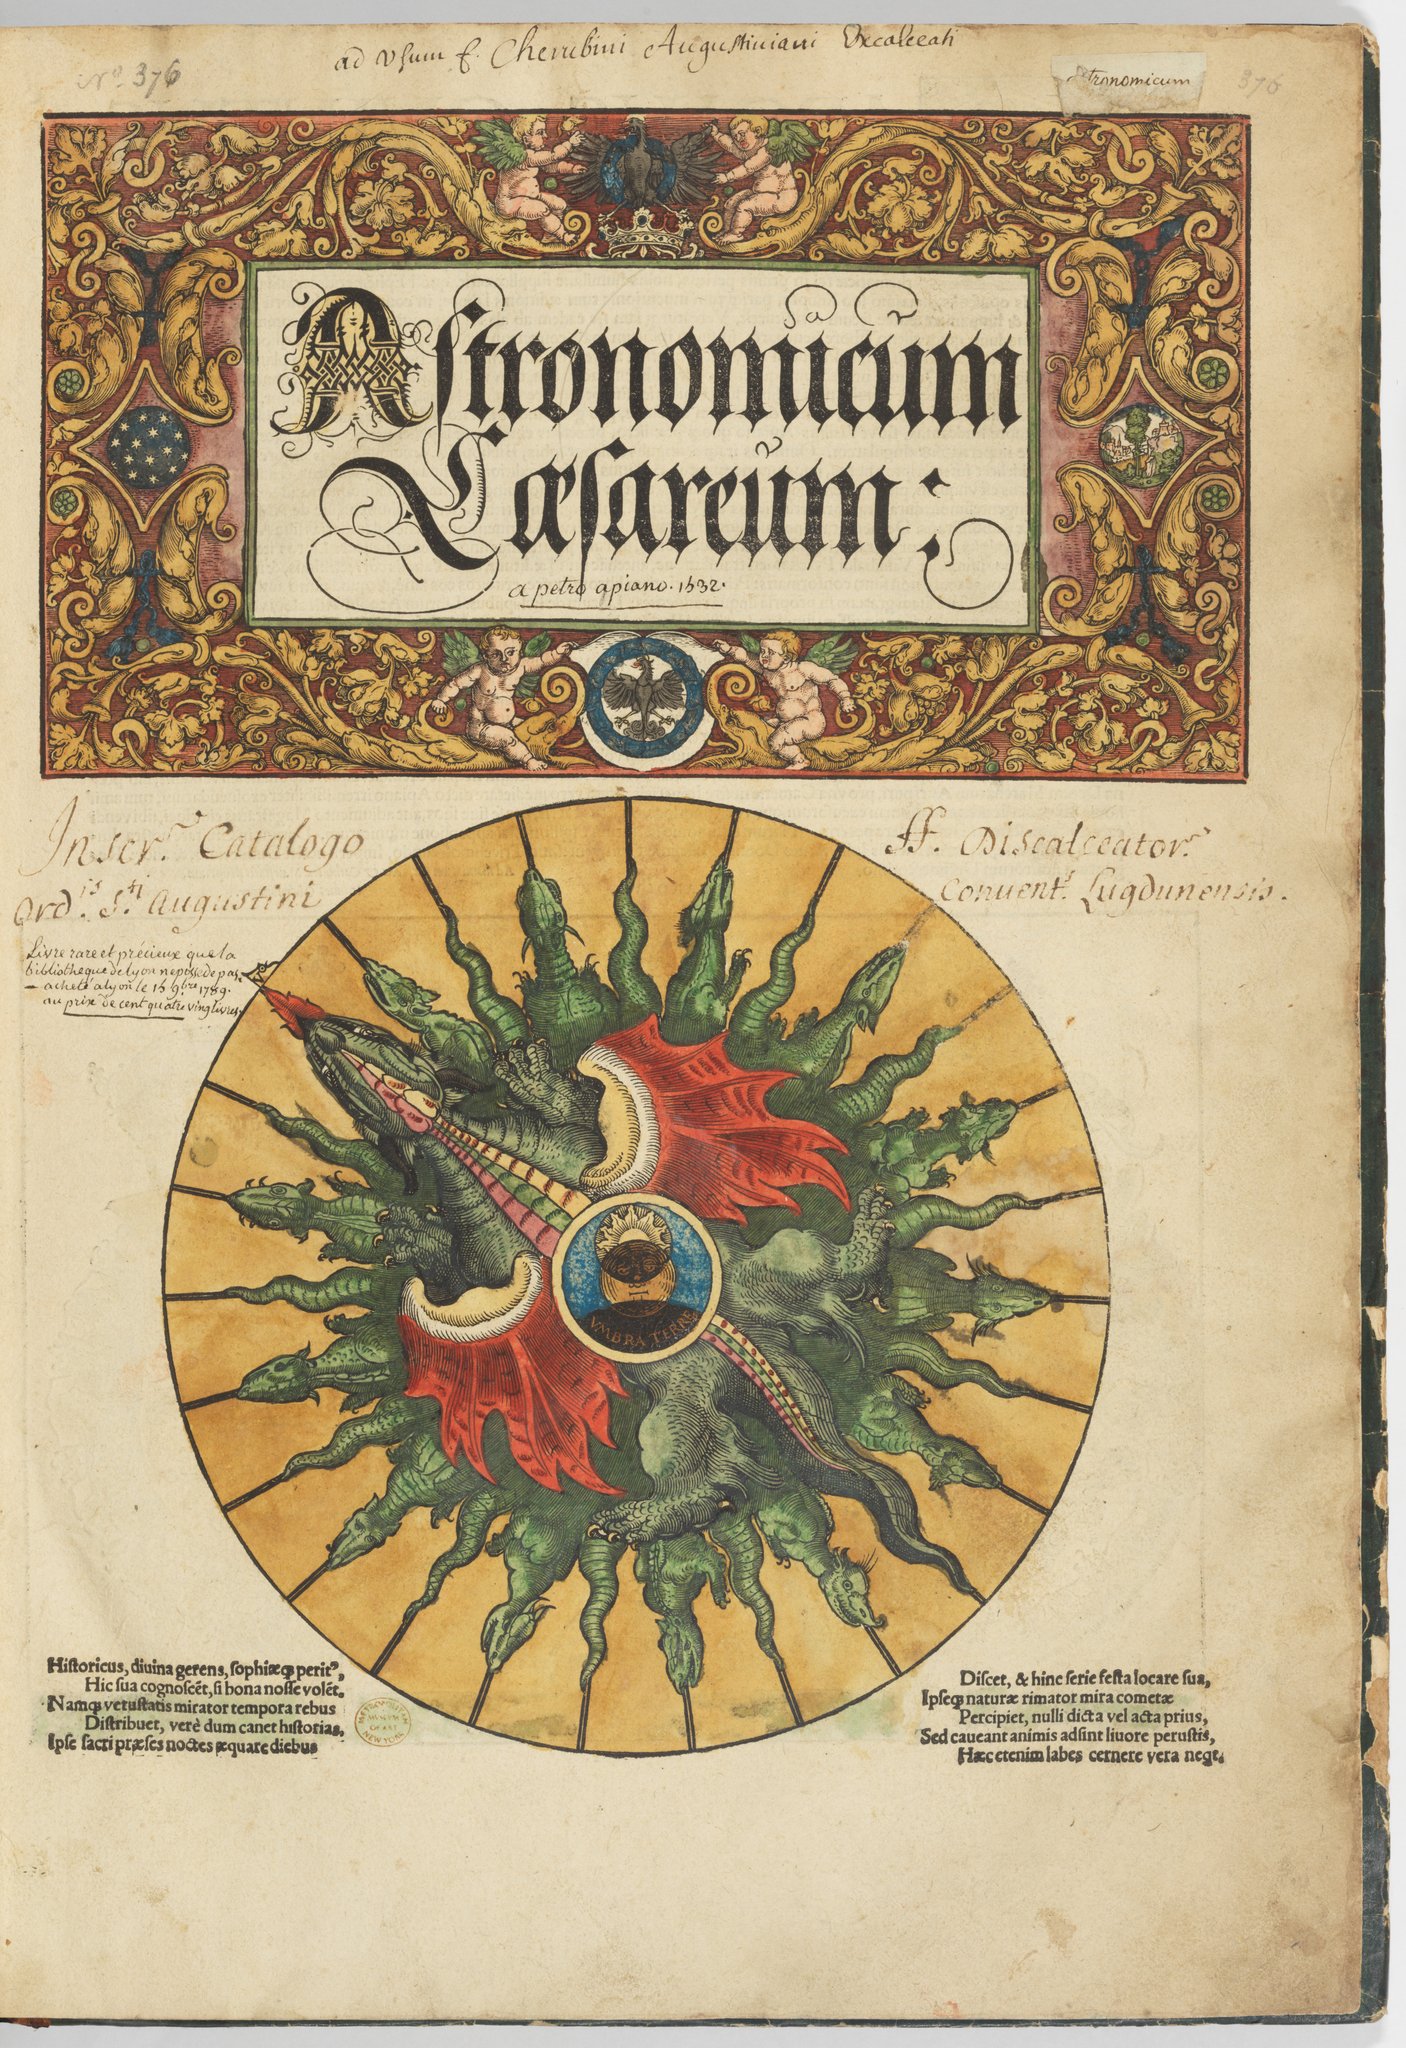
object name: book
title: Astronomicum Caesareum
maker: michael ostendorfer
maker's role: artist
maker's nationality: german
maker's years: 1520-1549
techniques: hand coloring, woodcut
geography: germany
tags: astronomy